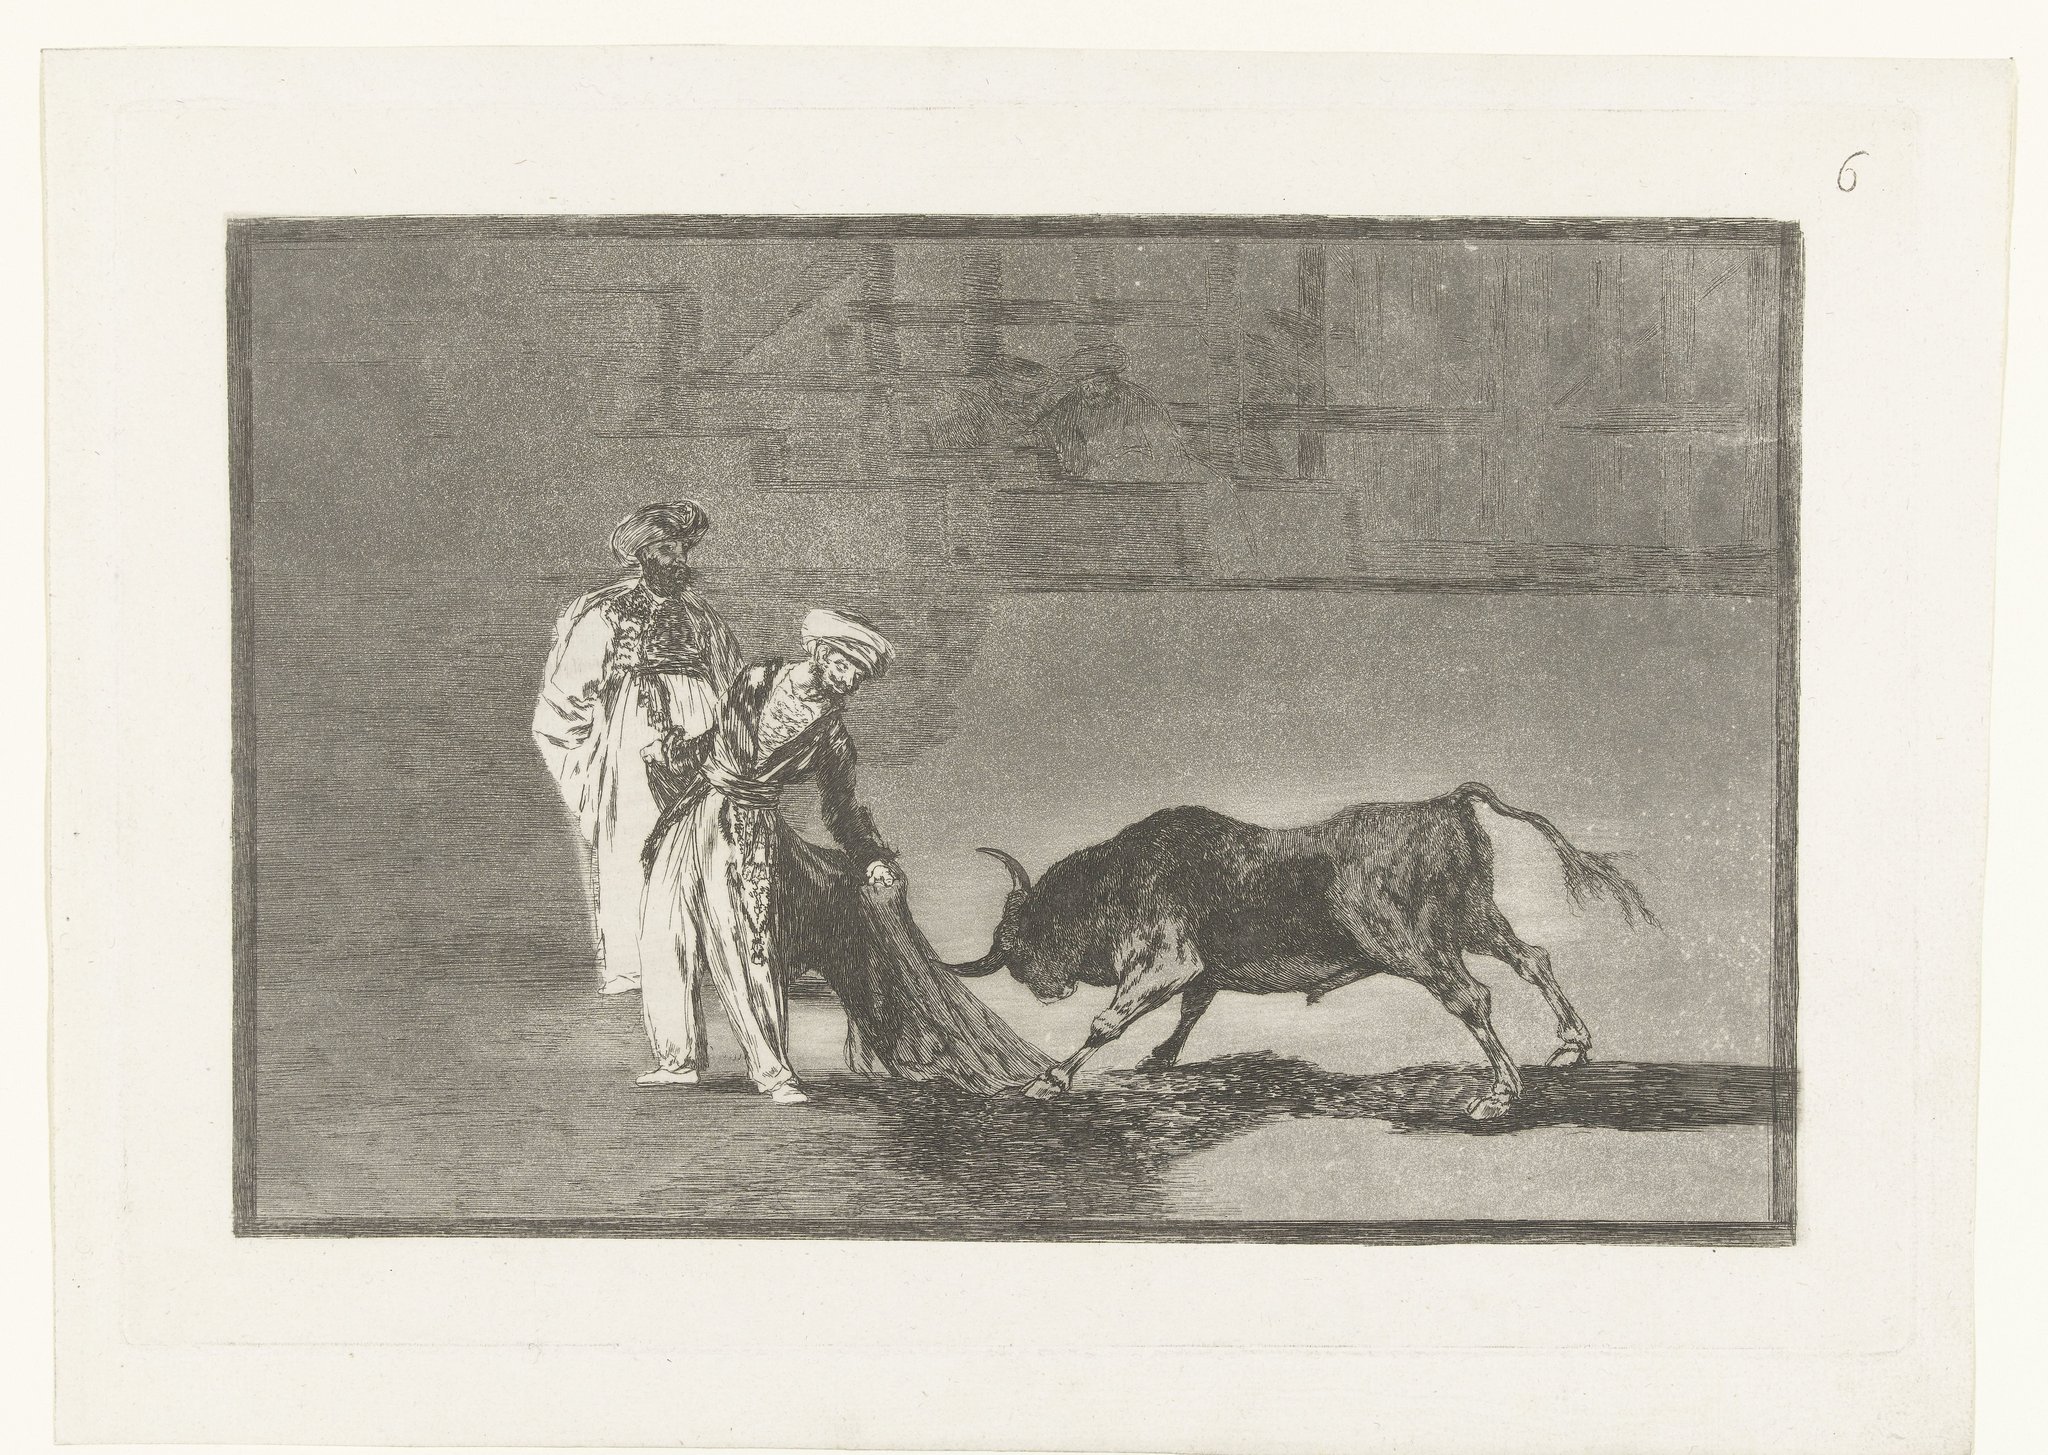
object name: print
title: Stierenvechten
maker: francisco de goya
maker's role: draughtsman, painter, print maker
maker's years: 1746-1828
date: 1811-1816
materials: paper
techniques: aquatint, drypoint, etching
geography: spain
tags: bull, bullfight, head-gear: turban, bull-fighter, toreador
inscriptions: collector's mark: Lugt 2228, collector's mark: Lugt 805b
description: Twee torero's (stierenvechters) in Moorse kledij vechten met een stier in een arena. Eén van de mannen daagt de stier uit met een mantel.